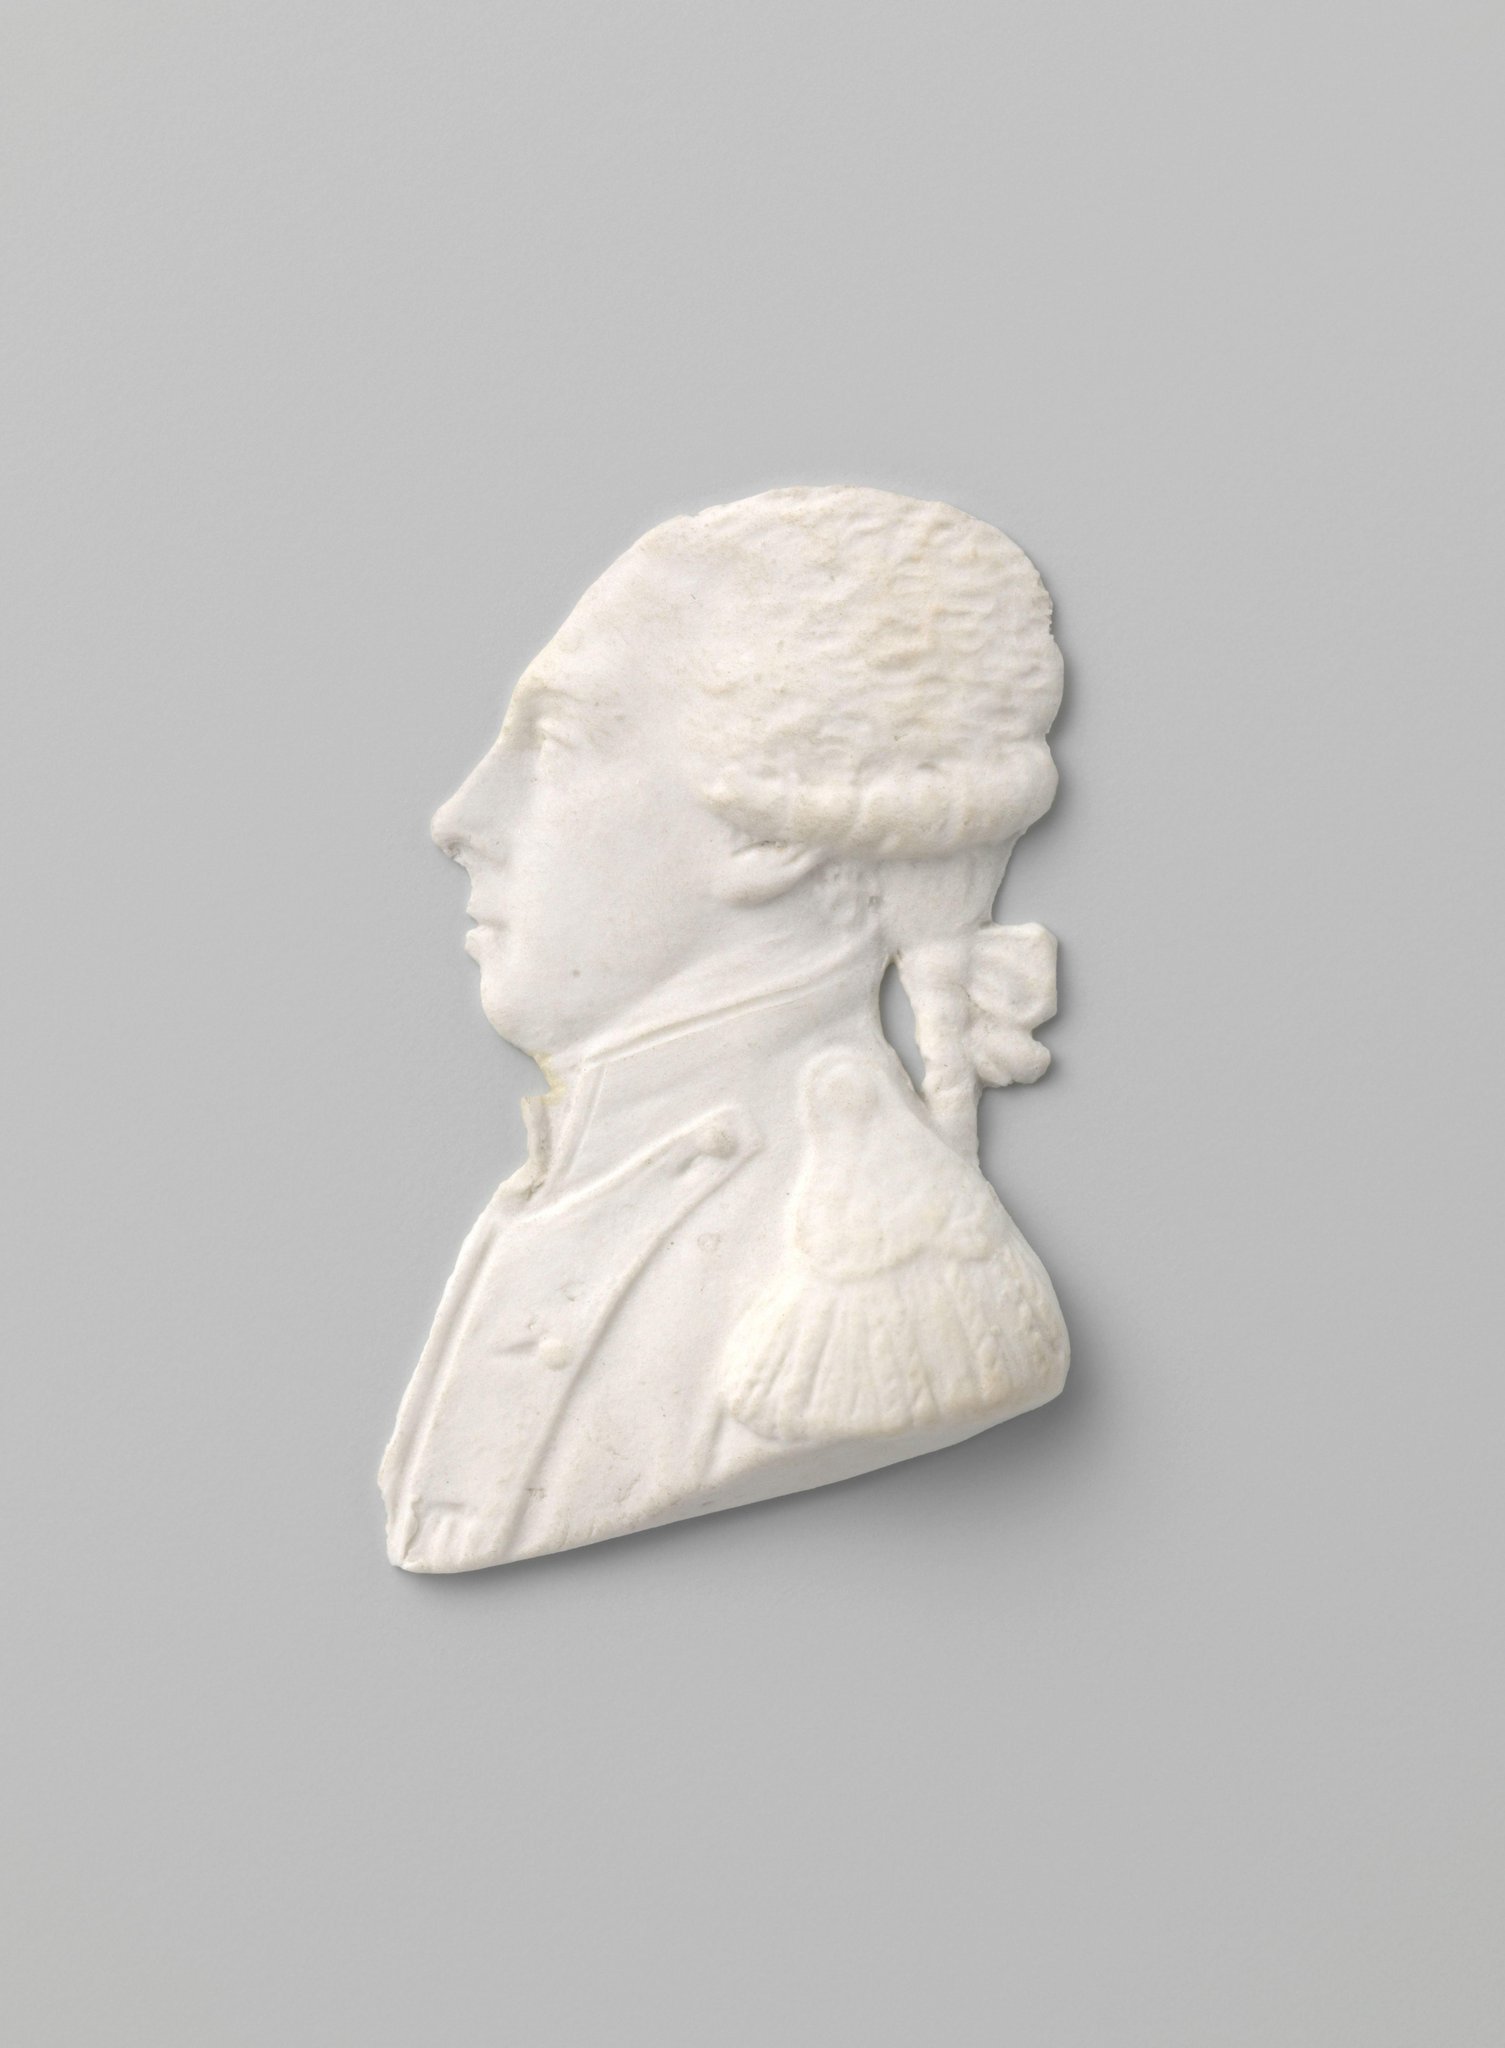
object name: relief sculpture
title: Portrait of Lafayette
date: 1780-1795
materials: porcelain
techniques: forming, relief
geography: sèvres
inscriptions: inscription: ‘LAF.’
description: Five portraits, from left to right: Benjamin Franklin, the Marquis de La Fayette, the Comte de Mirabeau, Jean-Jacques Rousseau and Marie Antoinette. Biscuit porcelain. Sèvres, c. 1780 - 1795. On loan from the Koninklijk Oudheidkundig Genootschap.